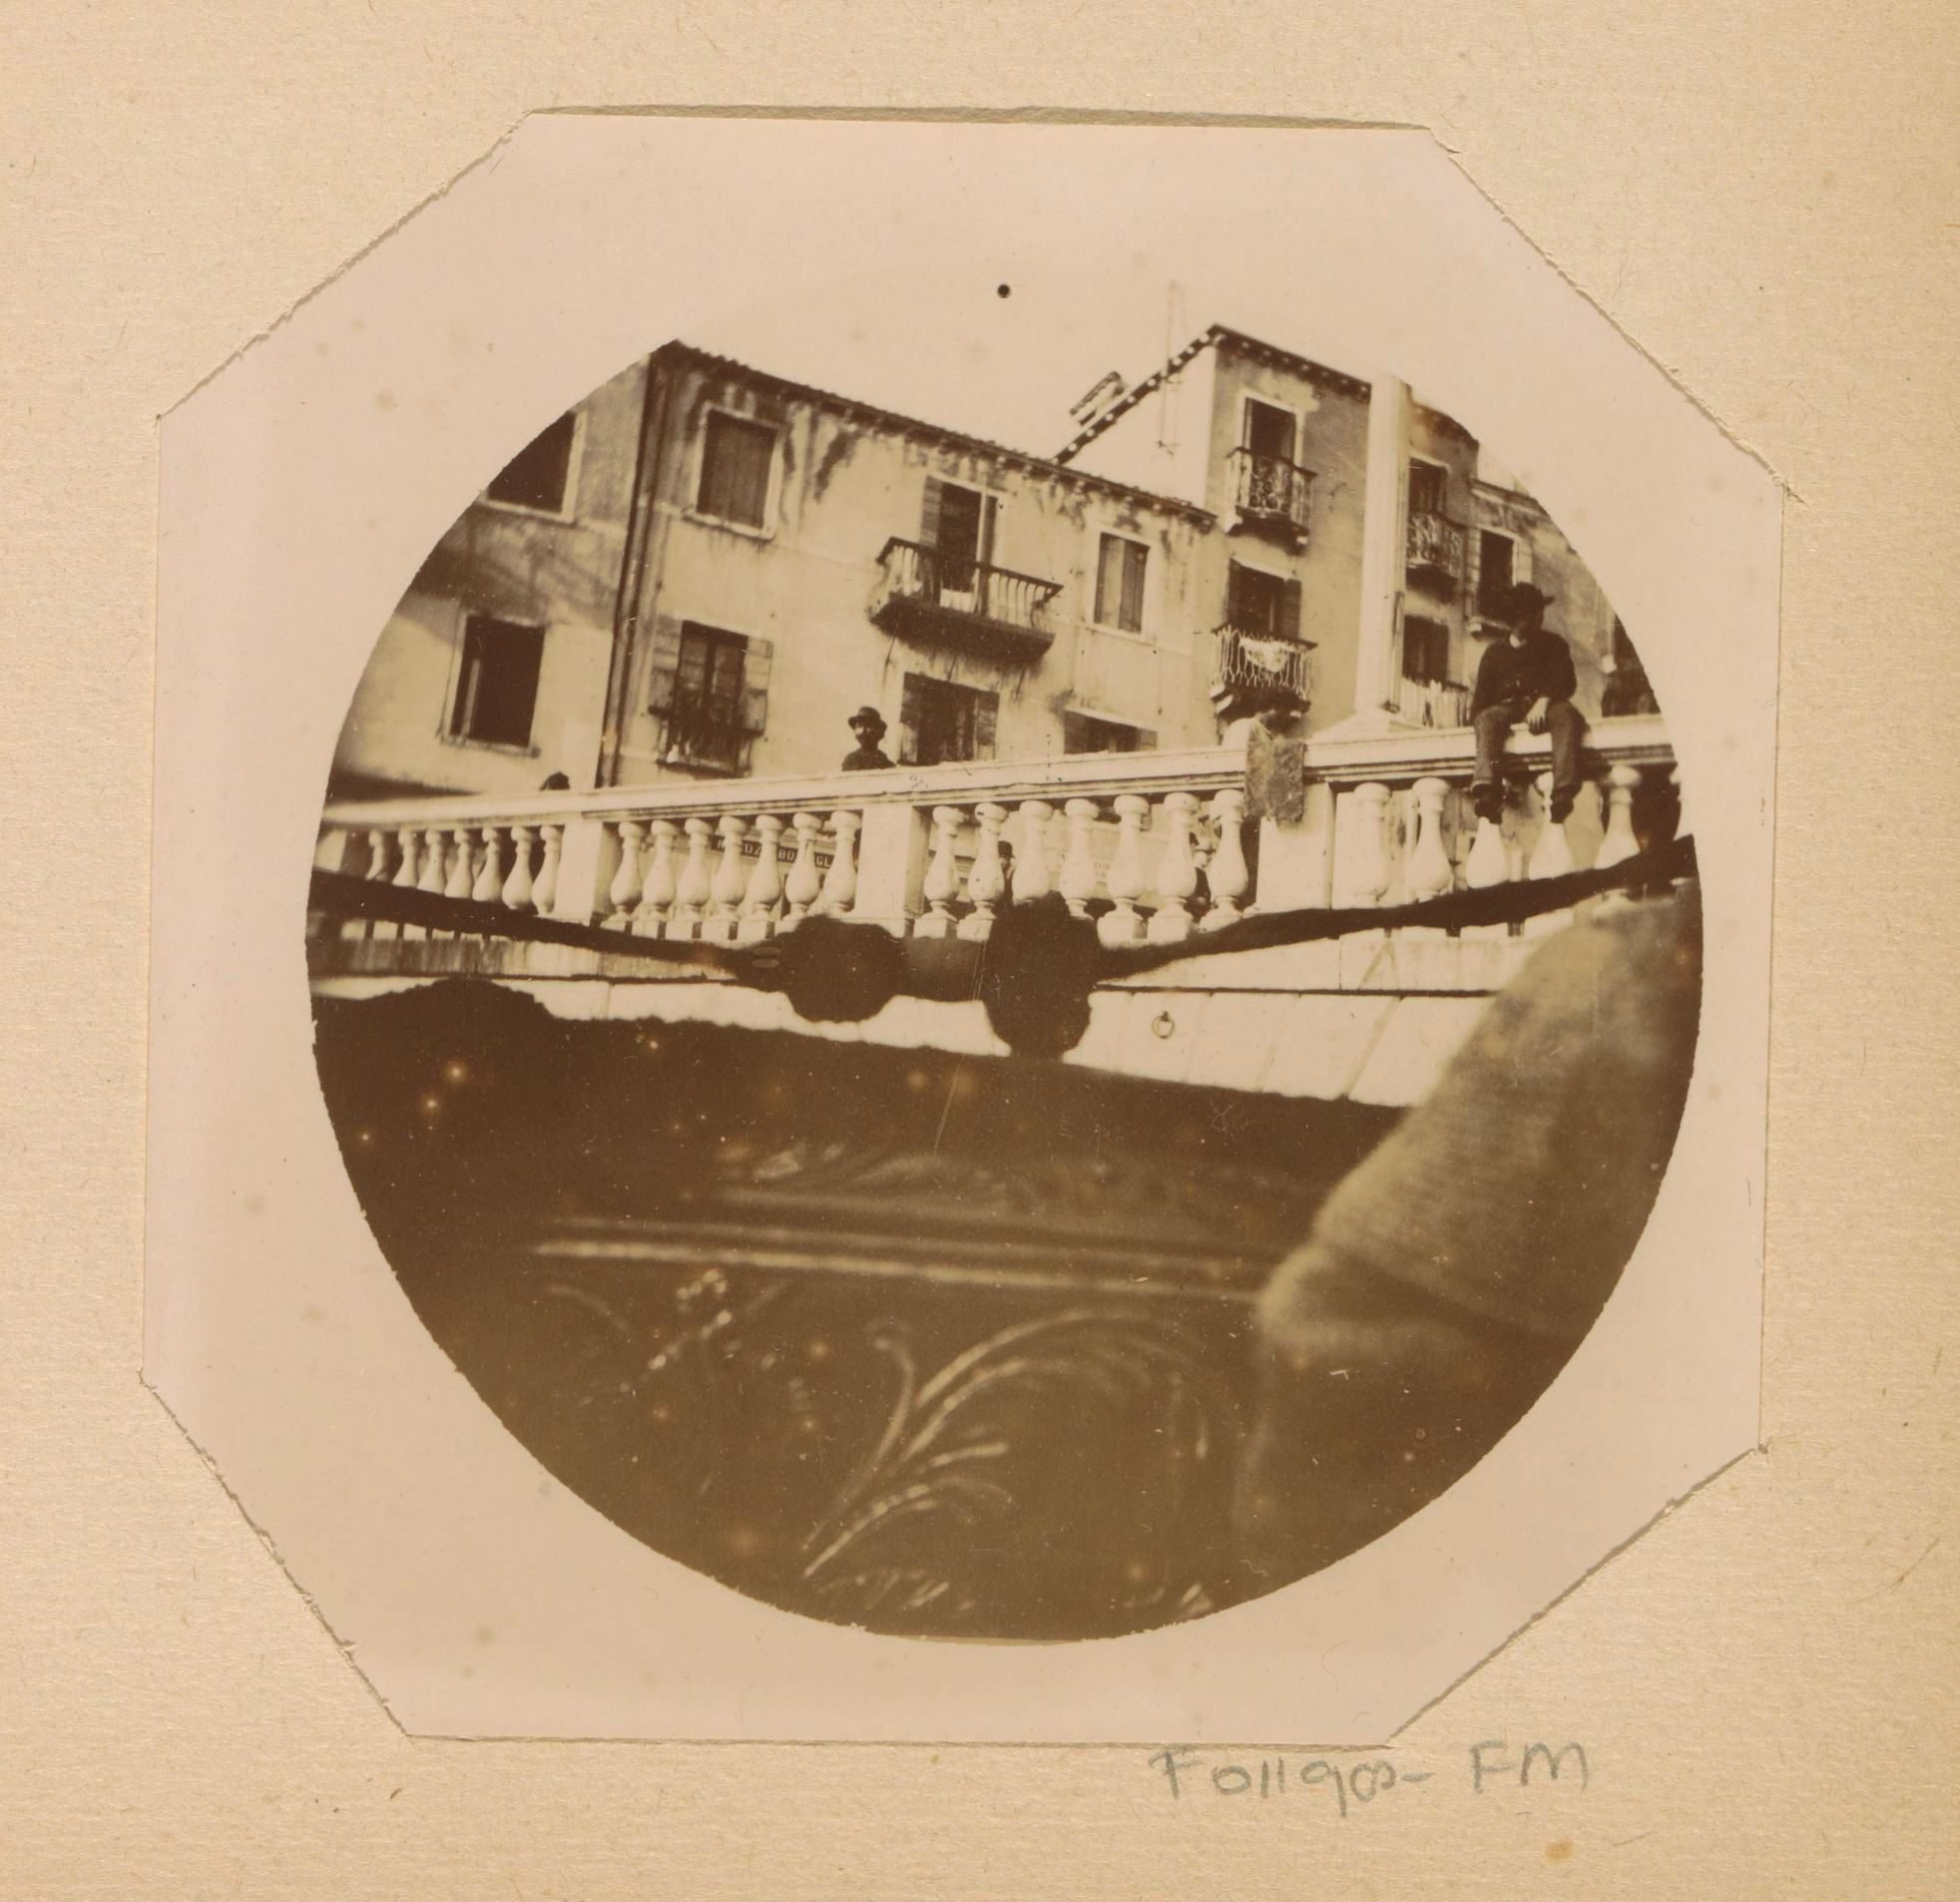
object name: photograph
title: Uitzicht op een brug in Venetië vanuit een gondel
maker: johanna margaretha piek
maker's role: fotograaf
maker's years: 1870-1947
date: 1889-1893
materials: paper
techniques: gelatin silver print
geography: venice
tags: bridge in city across river, canal, etc., gondola, venice